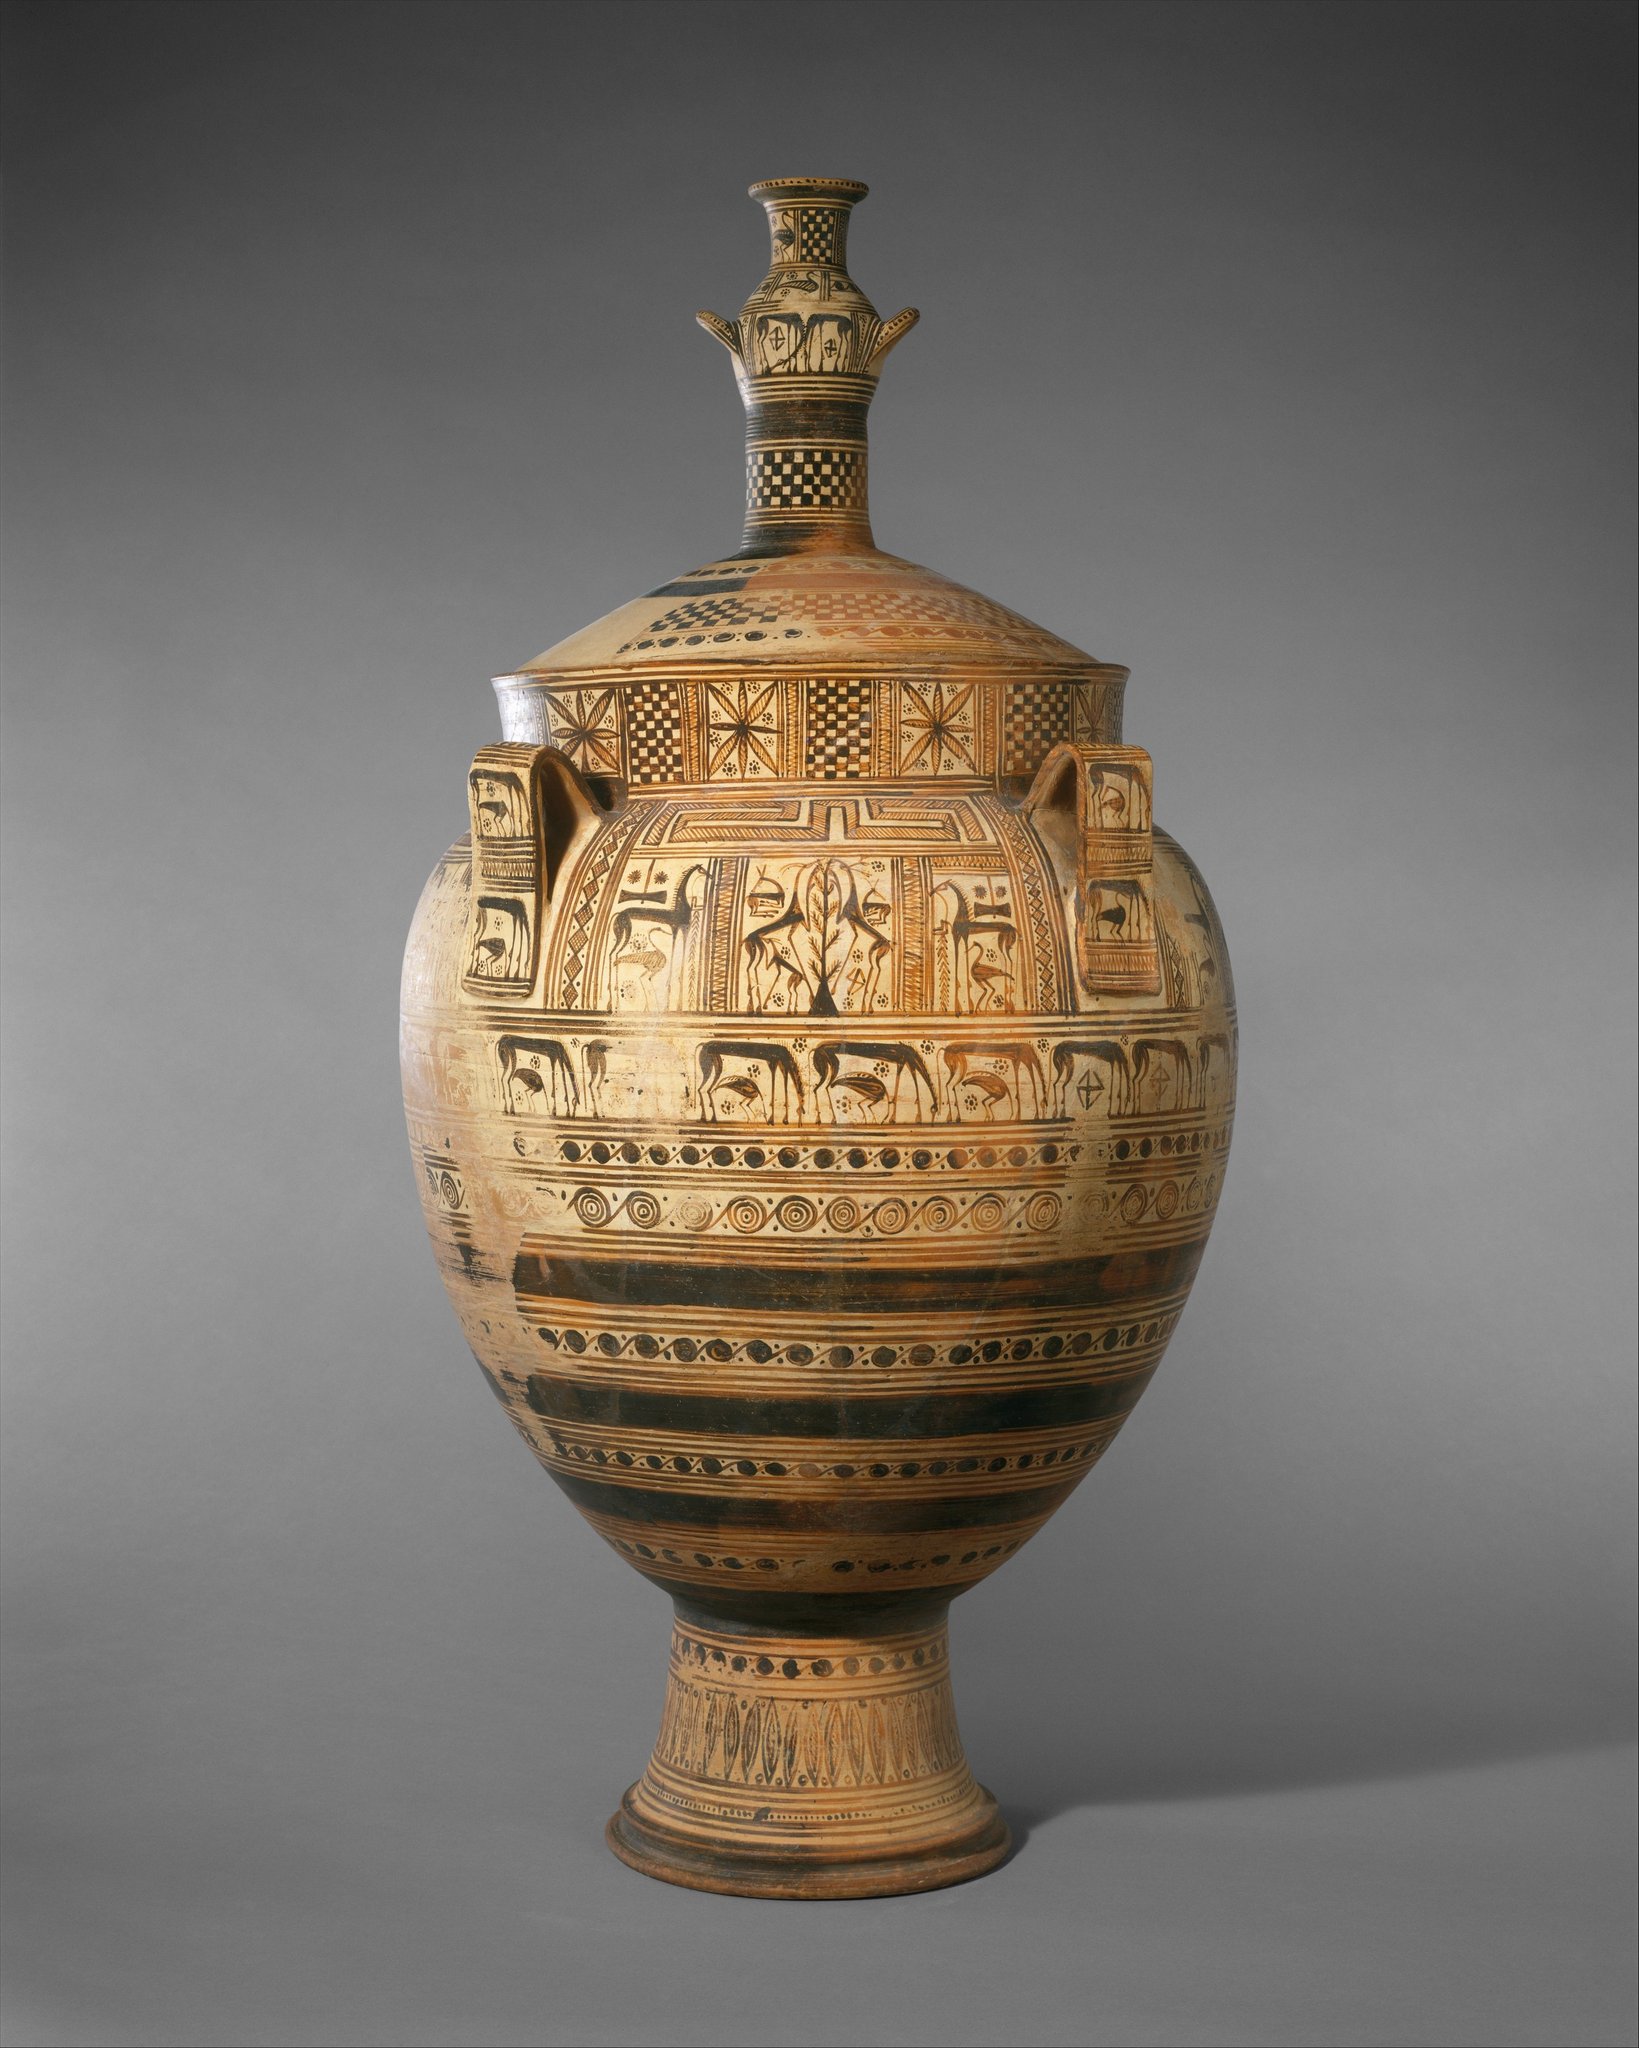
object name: krater, four handled with lid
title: Terracotta krater with lid surmounted by a small hydria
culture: greek, euboean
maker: cesnola painter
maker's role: artist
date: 750-740 BCE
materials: terracotta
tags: birds,deer,horses,axes